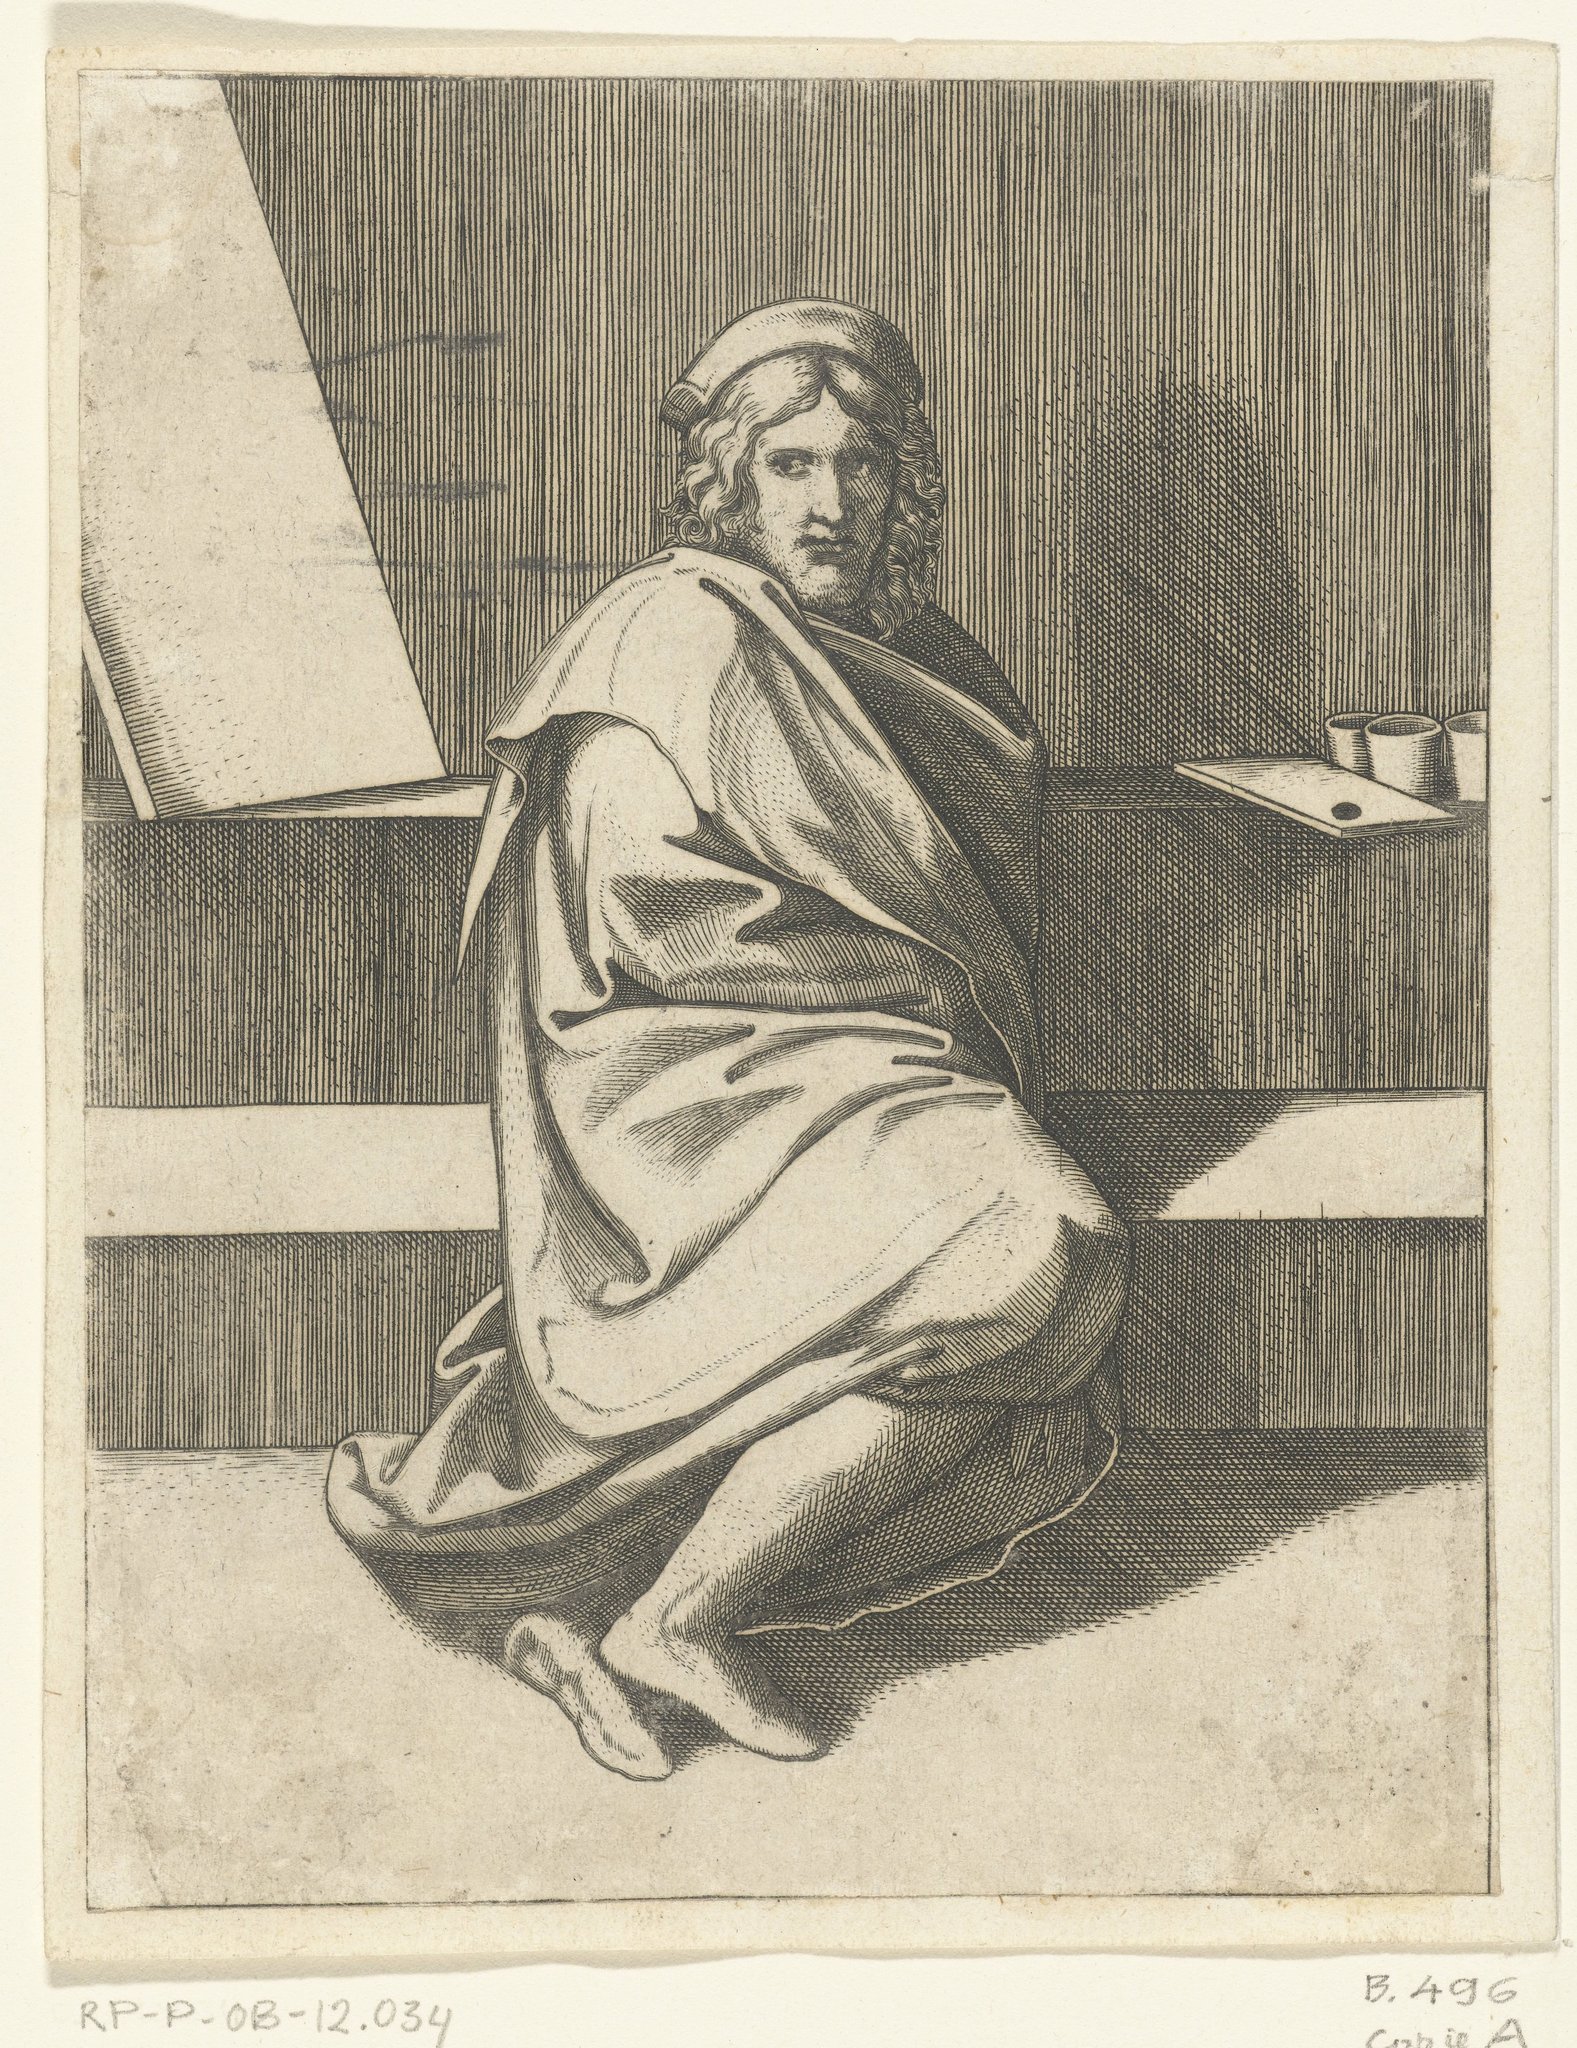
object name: print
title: Portret van schilder Raphael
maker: Anonymous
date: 1510-1575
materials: paper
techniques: engraving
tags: painter, rafaël, portrait, self-portrait of artist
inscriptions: collector's mark: Lugt 240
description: Kopie in spiegelbeeld naar prent van Marcantonio Raimondi.